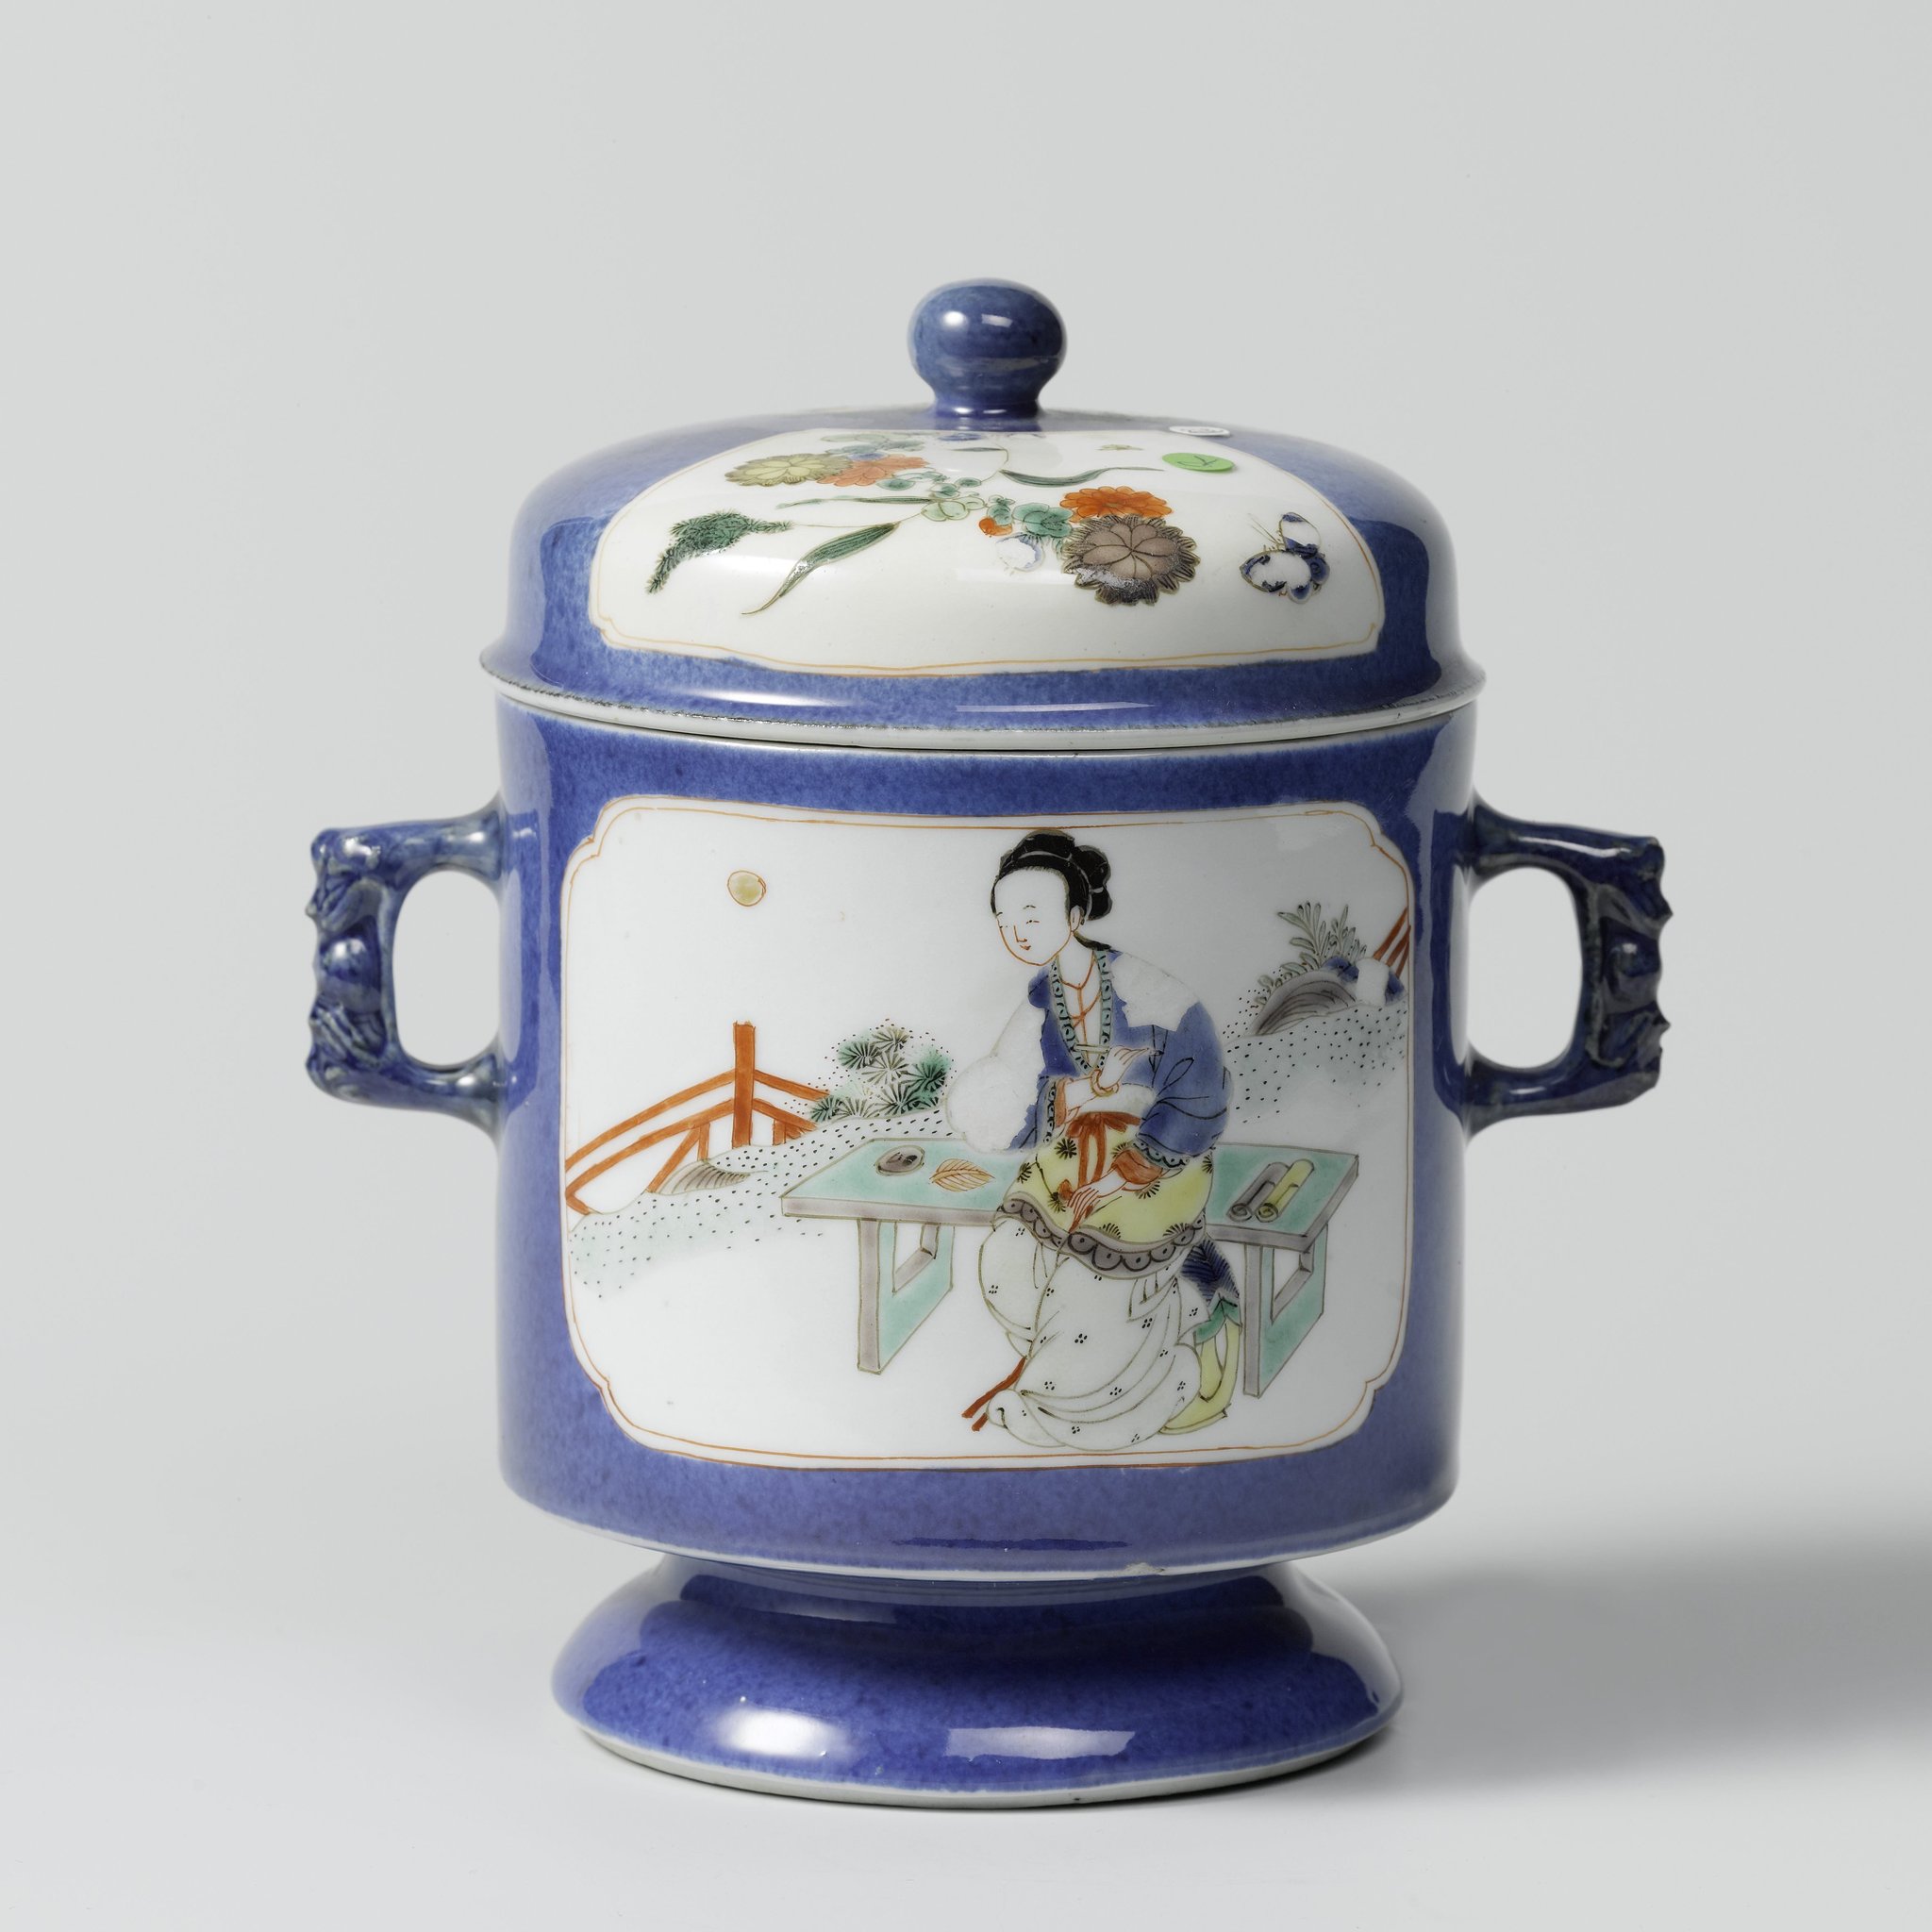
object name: covered jar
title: Lidded Jar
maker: Anonymous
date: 1700-1724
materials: cobalt, glaze, gold, paint, porcelain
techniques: firing, forming, gilding, turning, vitrification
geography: china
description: AK-NM-6362 dekselpot op voet • Bleu poudré-porselein met verte • Onderdeel van Royers porseleincollectie • Mogelijk afkomstig van Susanna Louise Huygens Royer had precies deze vorm pot ook in blauw-wit porselein. Zie AK-NM-6839-A voor een toelichting. De pot wordt daar een suikerpot genoemd en het is goed mogelijk dat dergelijke potten op deze manier gebruikt werden. Opgemerkt kan nog worden dat deze potten een uitwerking lijken te zijn van de eenvoudiger dekselpotten zonder voet en zonder oor en met een liggende ring op het deksel als dekselknop. Deze potten zijn algemeen in de Kangxi-periode en zijn op hun beurt weer een directe voortzetting van de sterk overeenkomstige dekselpotten in Kraakporselein. August de Sterke had deze eenvoudiger Kangxi-dekselpotten in grote hoeveelheden en uit de beschrijving ervan in de 18de-eeuwse inventarissen blijkt dat deze potjes als ‘pot a l’oille’ opgevat werden, een gedekselde soepkom. Mogelijk is deze elegantere dekselpot op voet hieruit voortgekomen, en waarschijnlijk is dan een uit hout gedraaid voorbeeld naar een zilveren pot, naar de pottenbakkers gestuurd. De decors zijn aantrekkelijk geschilderd, maar aan één kan is het veld niet recht in het vlak geplaatst en dat is storend. Het blauw is hier en daar afgesprongen, een veel voorkomend probleem juist bij die kleur. Op grond van aanwezigheid van blauw wordt deze dekselpot gerekend tot het iets latere poudré. Waarschijnlijk kocht Royer deze pot in 1786 uit de nalatenschap van zijn oudtante Susanna Louise Huygens (1714-1875). Royer kocht veel porselein en de omschrijving ‘Een hooge pot met twee oiren dito [hoog blaauw] met compartimenten, waarin Chineesche vrouwenbeelden in couleuren’ in Susanna’s boedelbeschrijving komt goed overeen met Royers dekselpot.